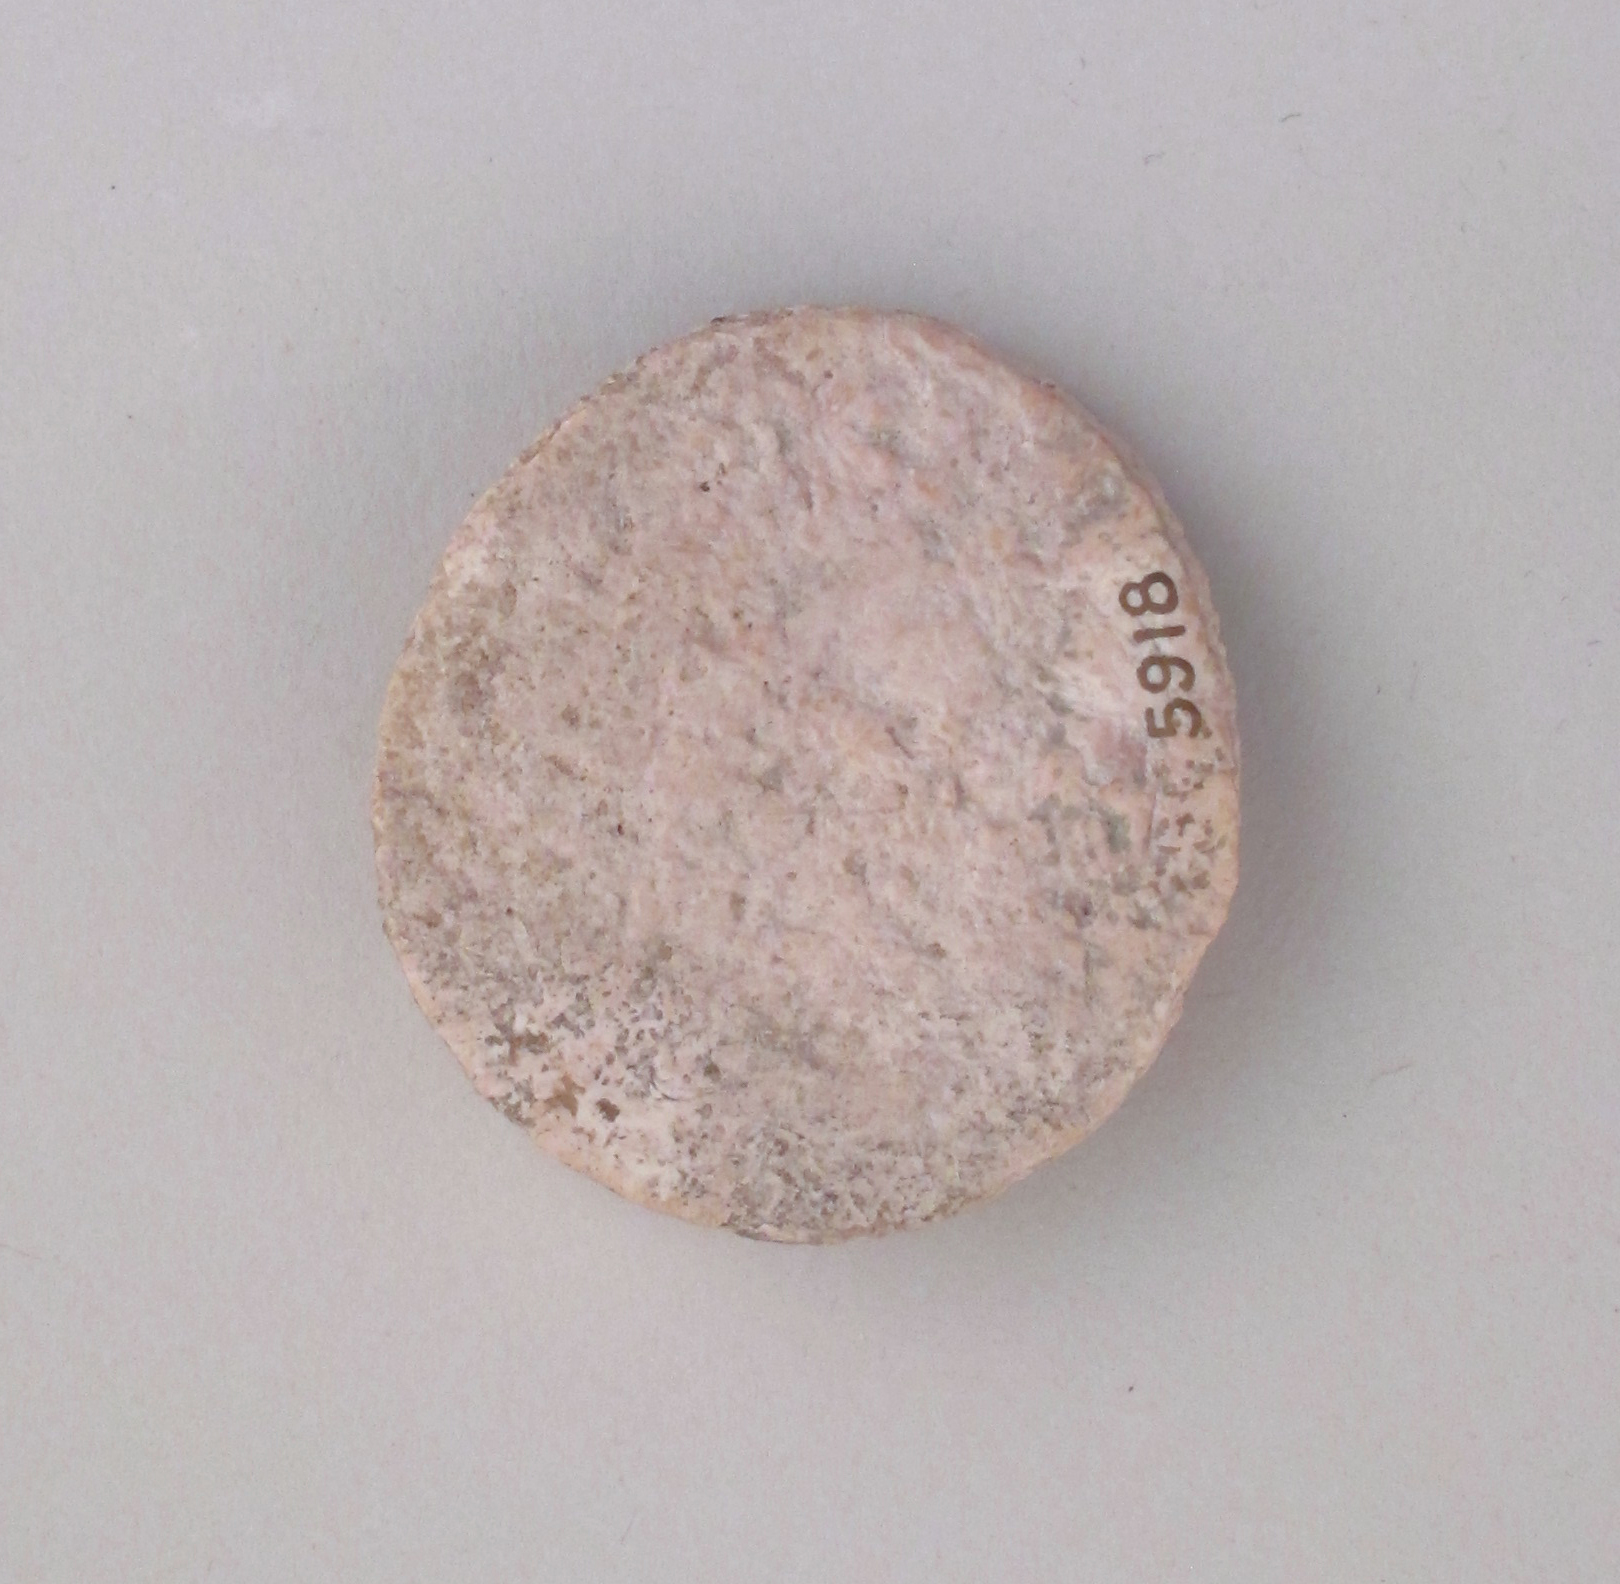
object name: roundel, disk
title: Ivory disk of a pyxis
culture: cypriot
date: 1300-1101 BCE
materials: ivory